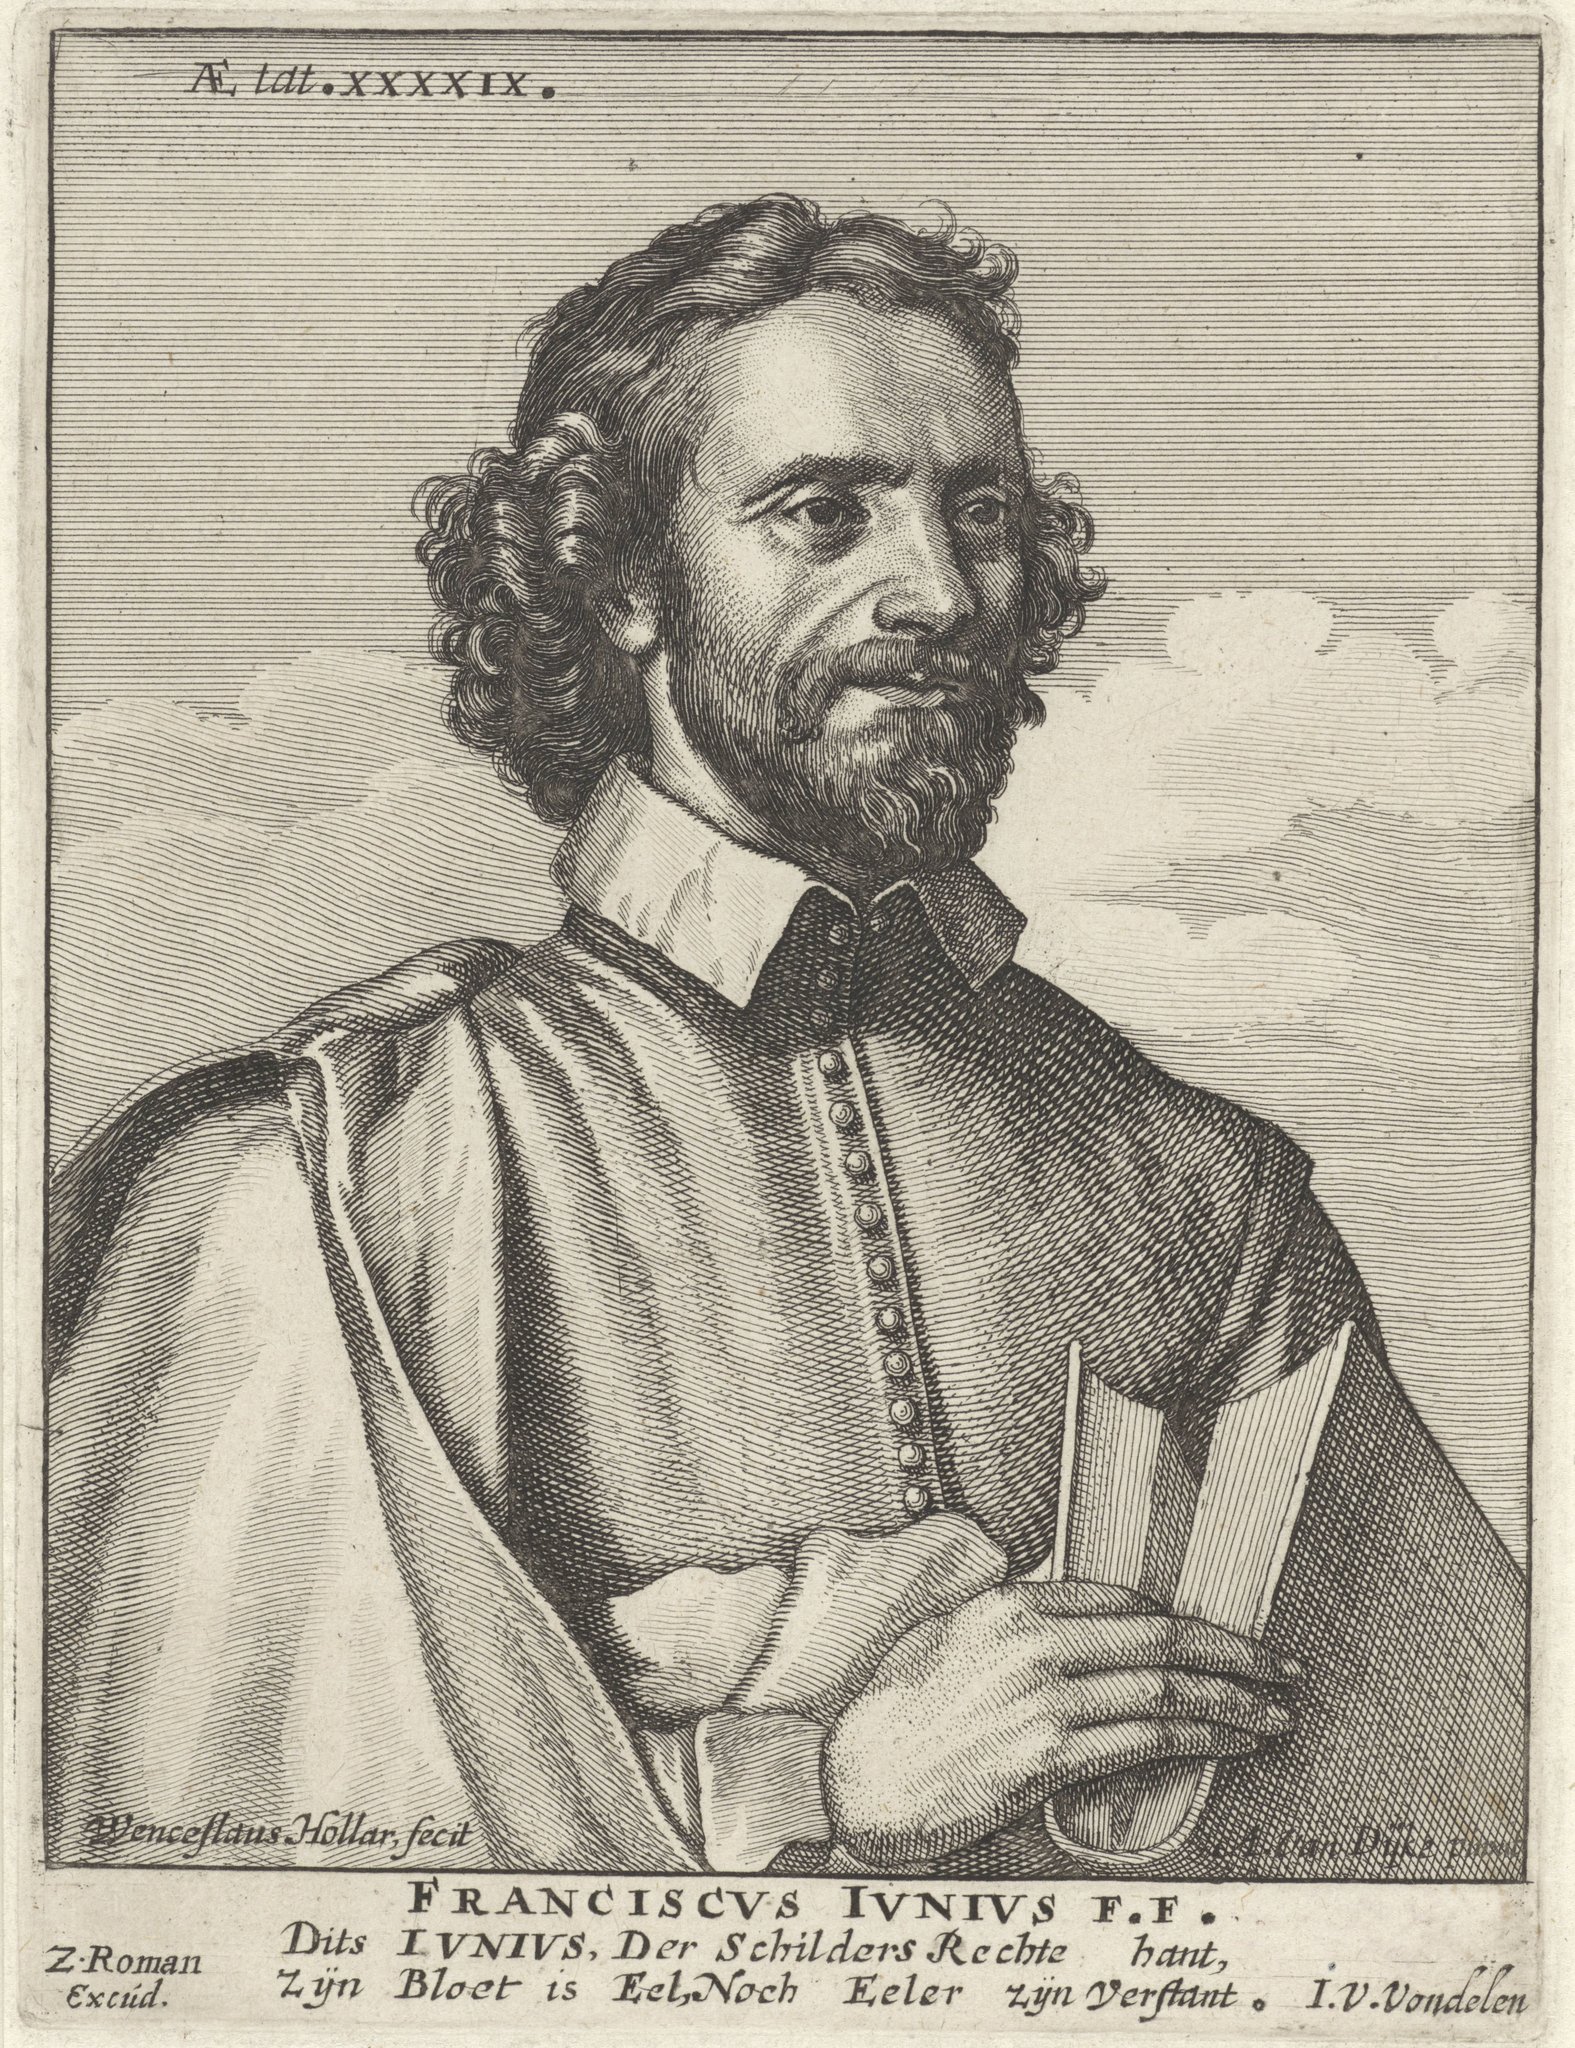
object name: print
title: Portret van Franciscus Junius de Jongere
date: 1641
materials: paper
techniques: etching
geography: london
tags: filoloog, franciscus junius (ii)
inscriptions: collector's mark: Lugt 240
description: Portret van de filoloog en oudheidkundige Franciscus Junius de Jongere.